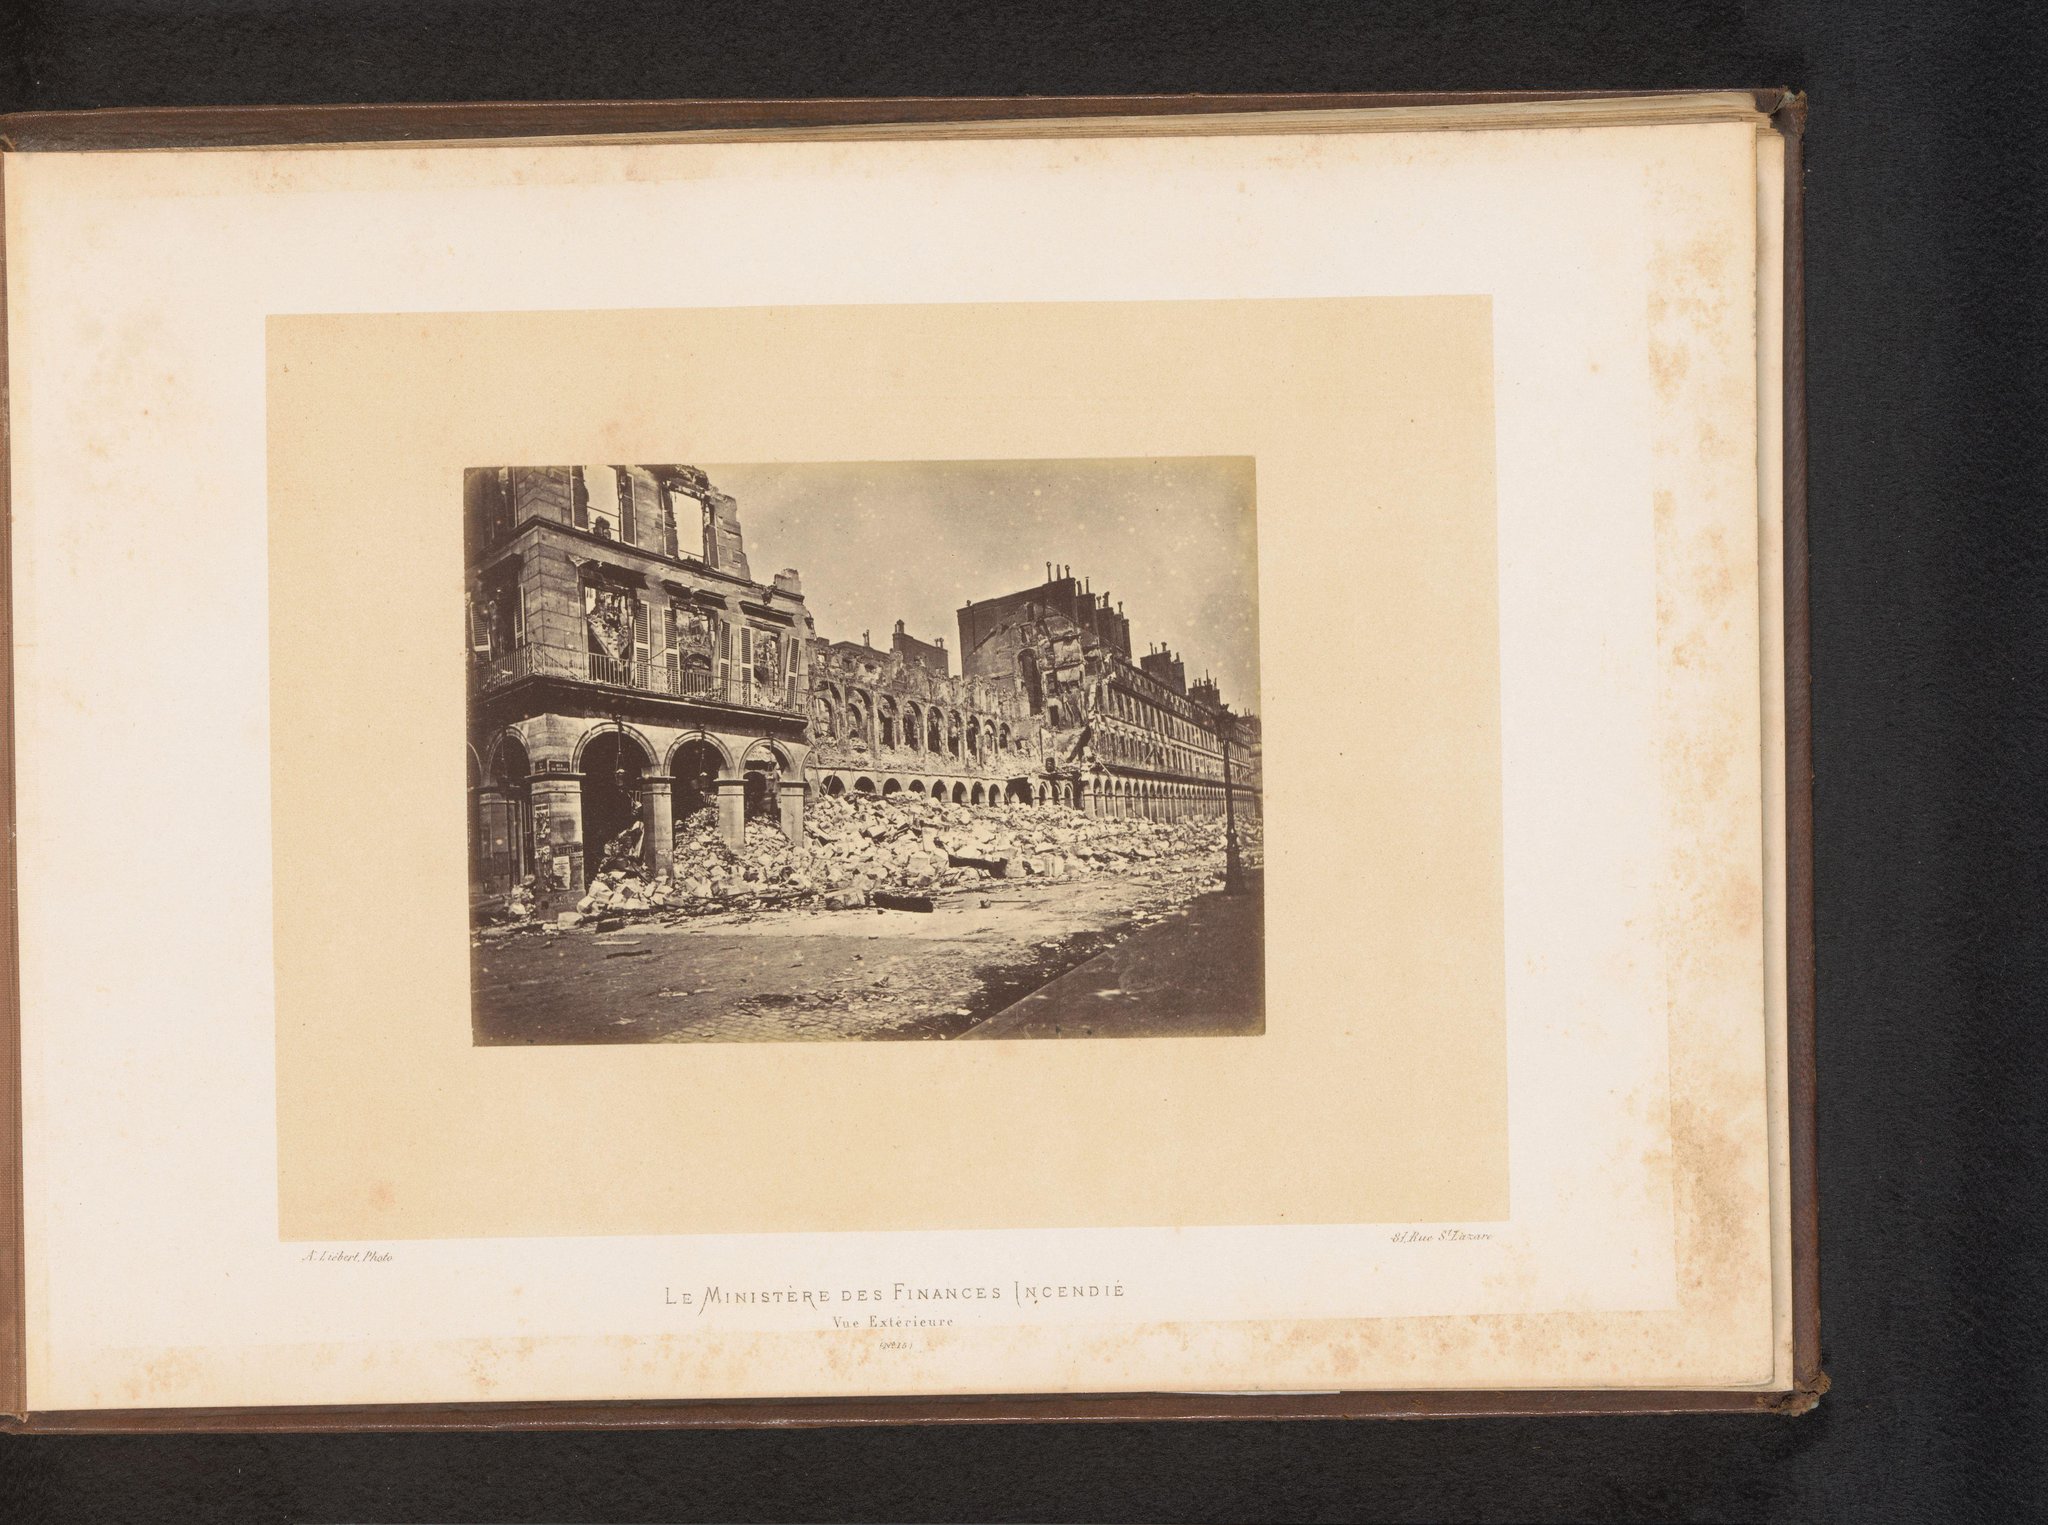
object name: page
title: Le Ministère des Finances Incendié. Vue Extérieure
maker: alphonse-justin liébert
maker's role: fotograaf, marinier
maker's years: 1827-1914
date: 1871-1872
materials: photographic support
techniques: albumen print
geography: paris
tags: ruin of a building ~ architecture, organization of trade and finance, national government, paris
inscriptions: address: ‘31, Rue St. Lazare’, number: ‘(No. 15)’